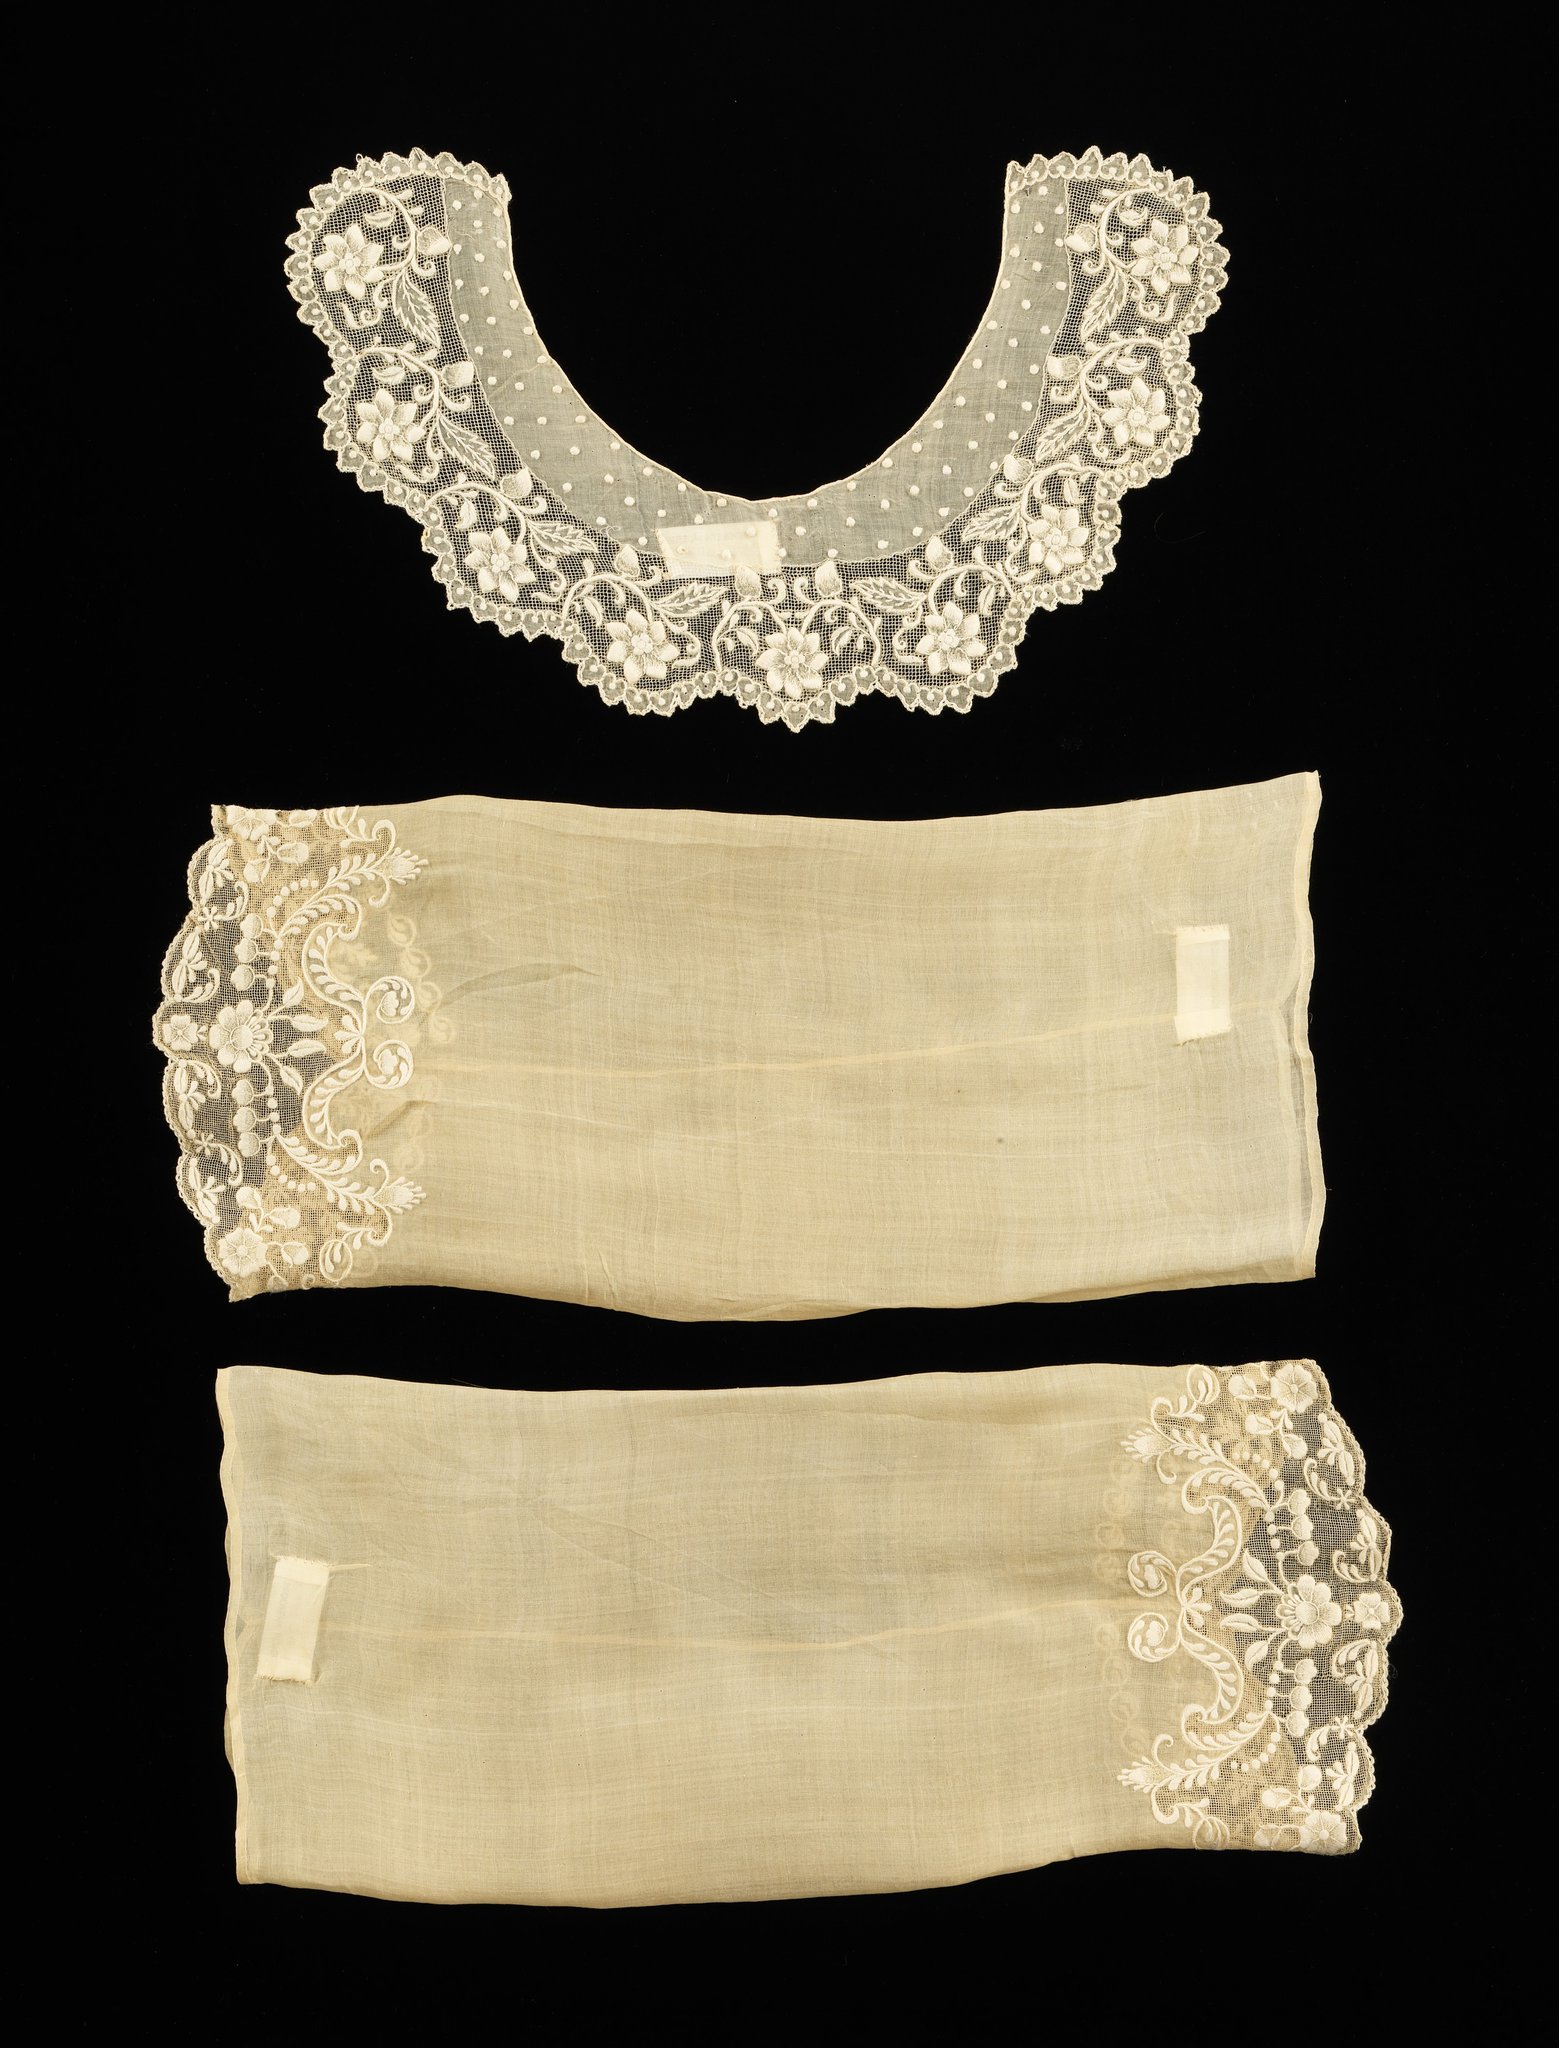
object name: accessory set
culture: philippine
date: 1850